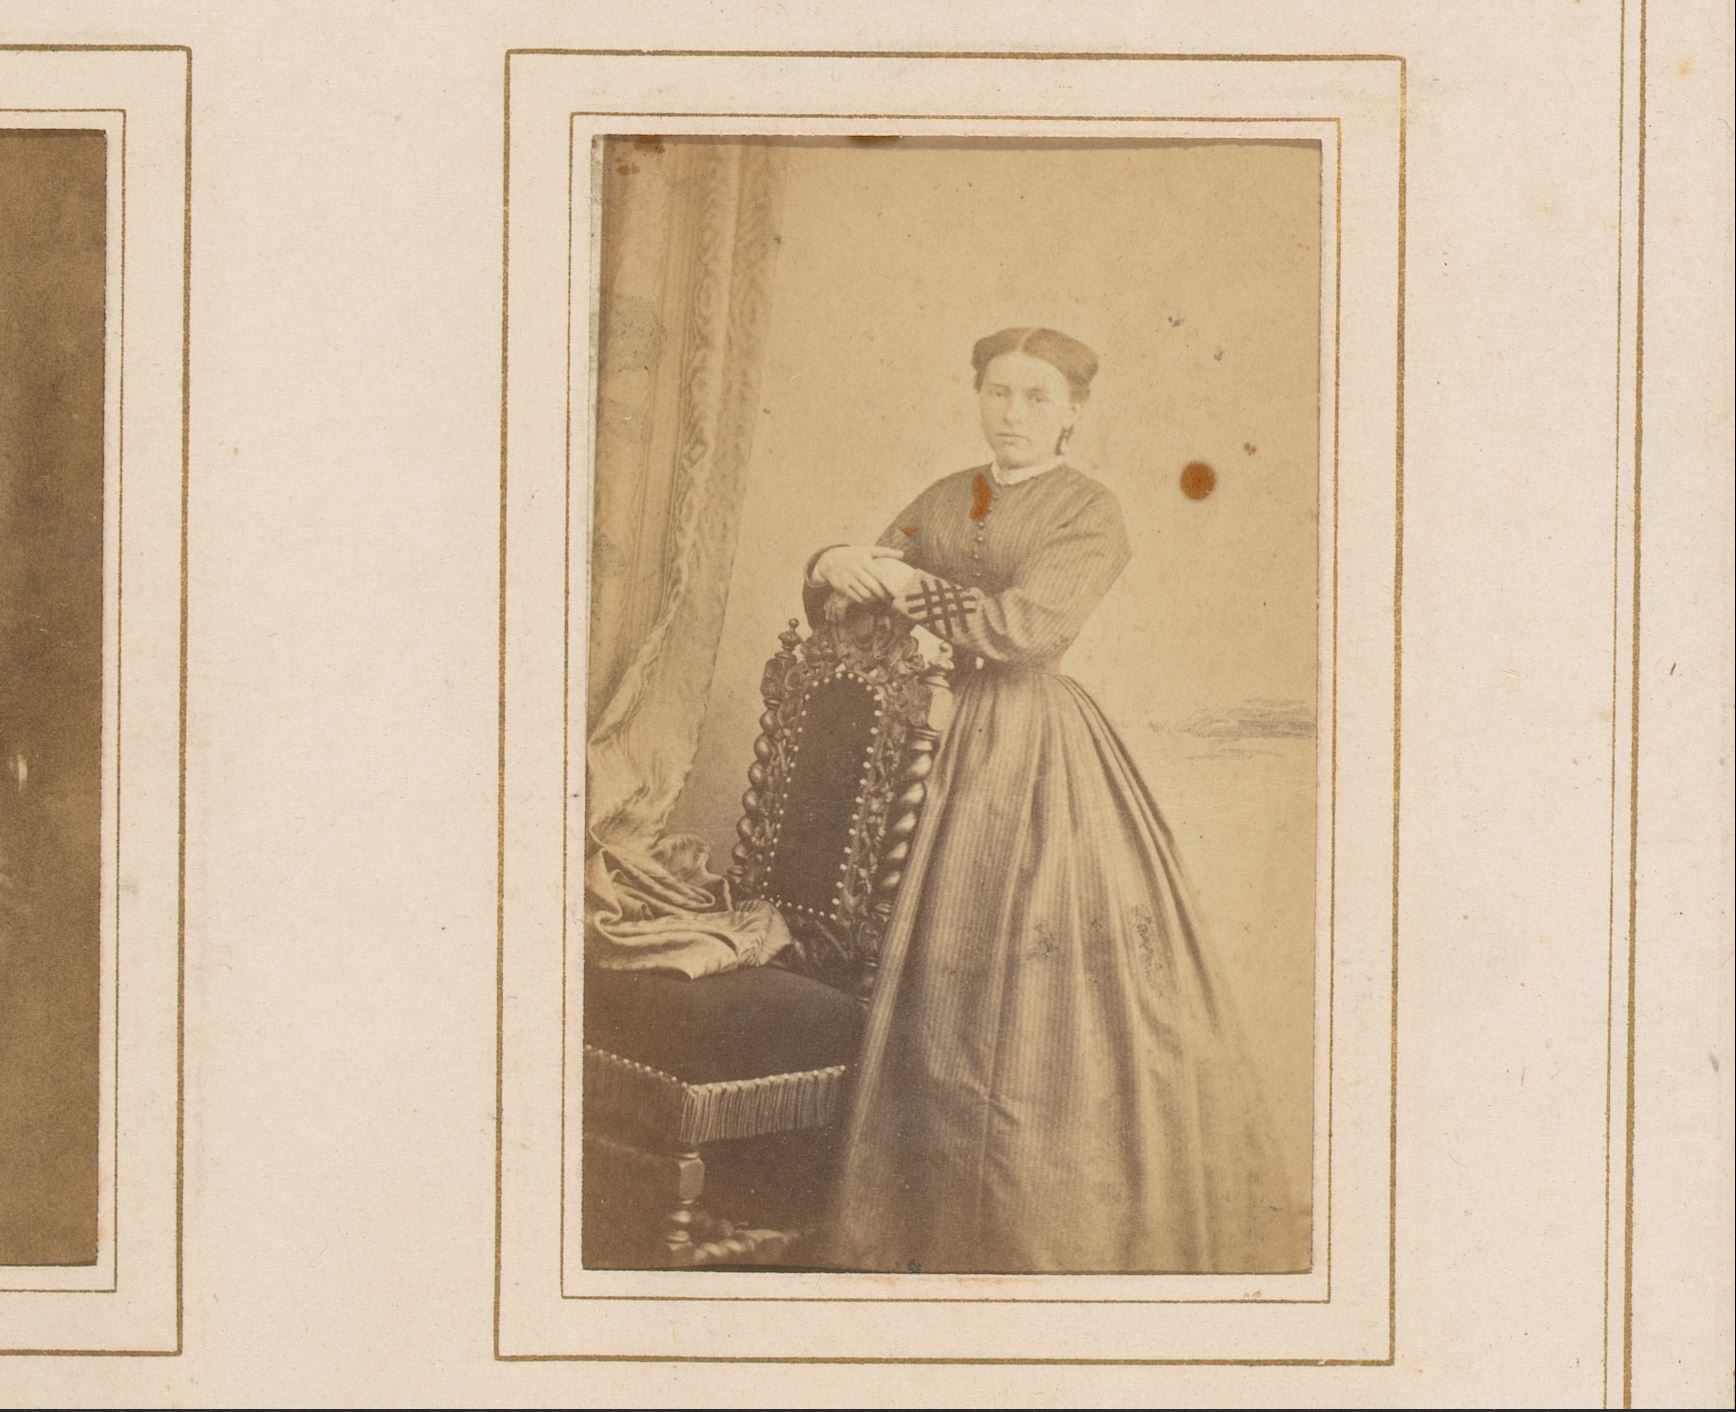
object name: photograph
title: Portret van een staande vrouw bij een stoel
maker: herman bückmann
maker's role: fotograaf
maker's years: 1820-1884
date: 1851-1884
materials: cardboard, photographic support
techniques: albumen print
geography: netherlands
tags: historical persons - bb - woman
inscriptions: inscription: ‘J.H. Buckmann/ 2 Wagenstraat No. 129/ 's Hage’